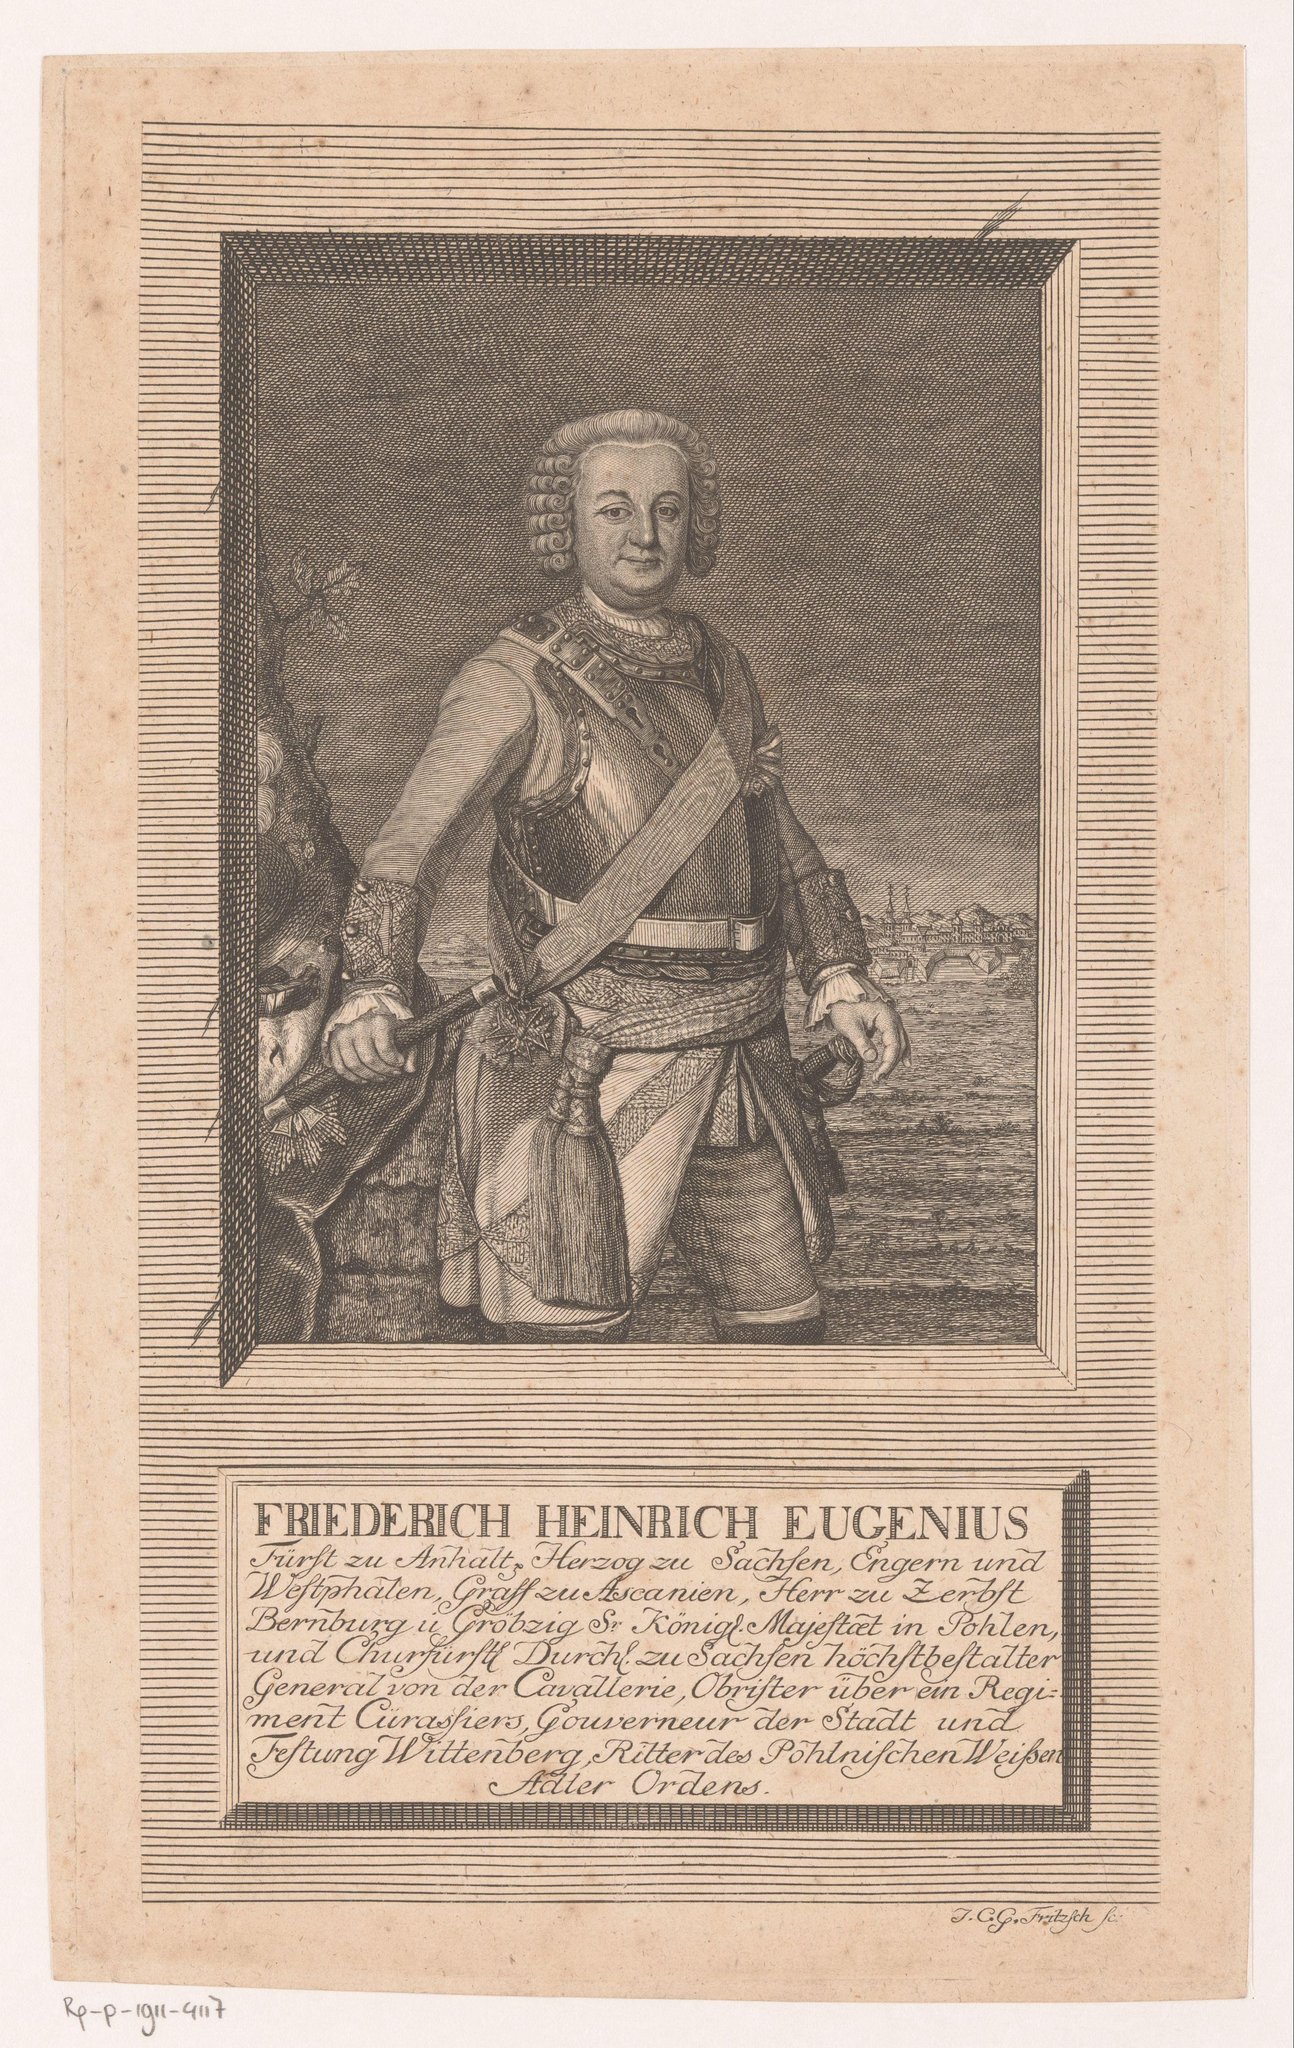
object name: print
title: Portret van Friedrich Heinrich Eugenius von Anhalt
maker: johann christian gottfried fritzsch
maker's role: print maker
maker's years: 1720-1802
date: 1730-1781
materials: paper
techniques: engraving, etching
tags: city-view in general; 'veduta', historical persons, medals and other marks of military honour, baton of general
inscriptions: collector's mark: Lugt 2228